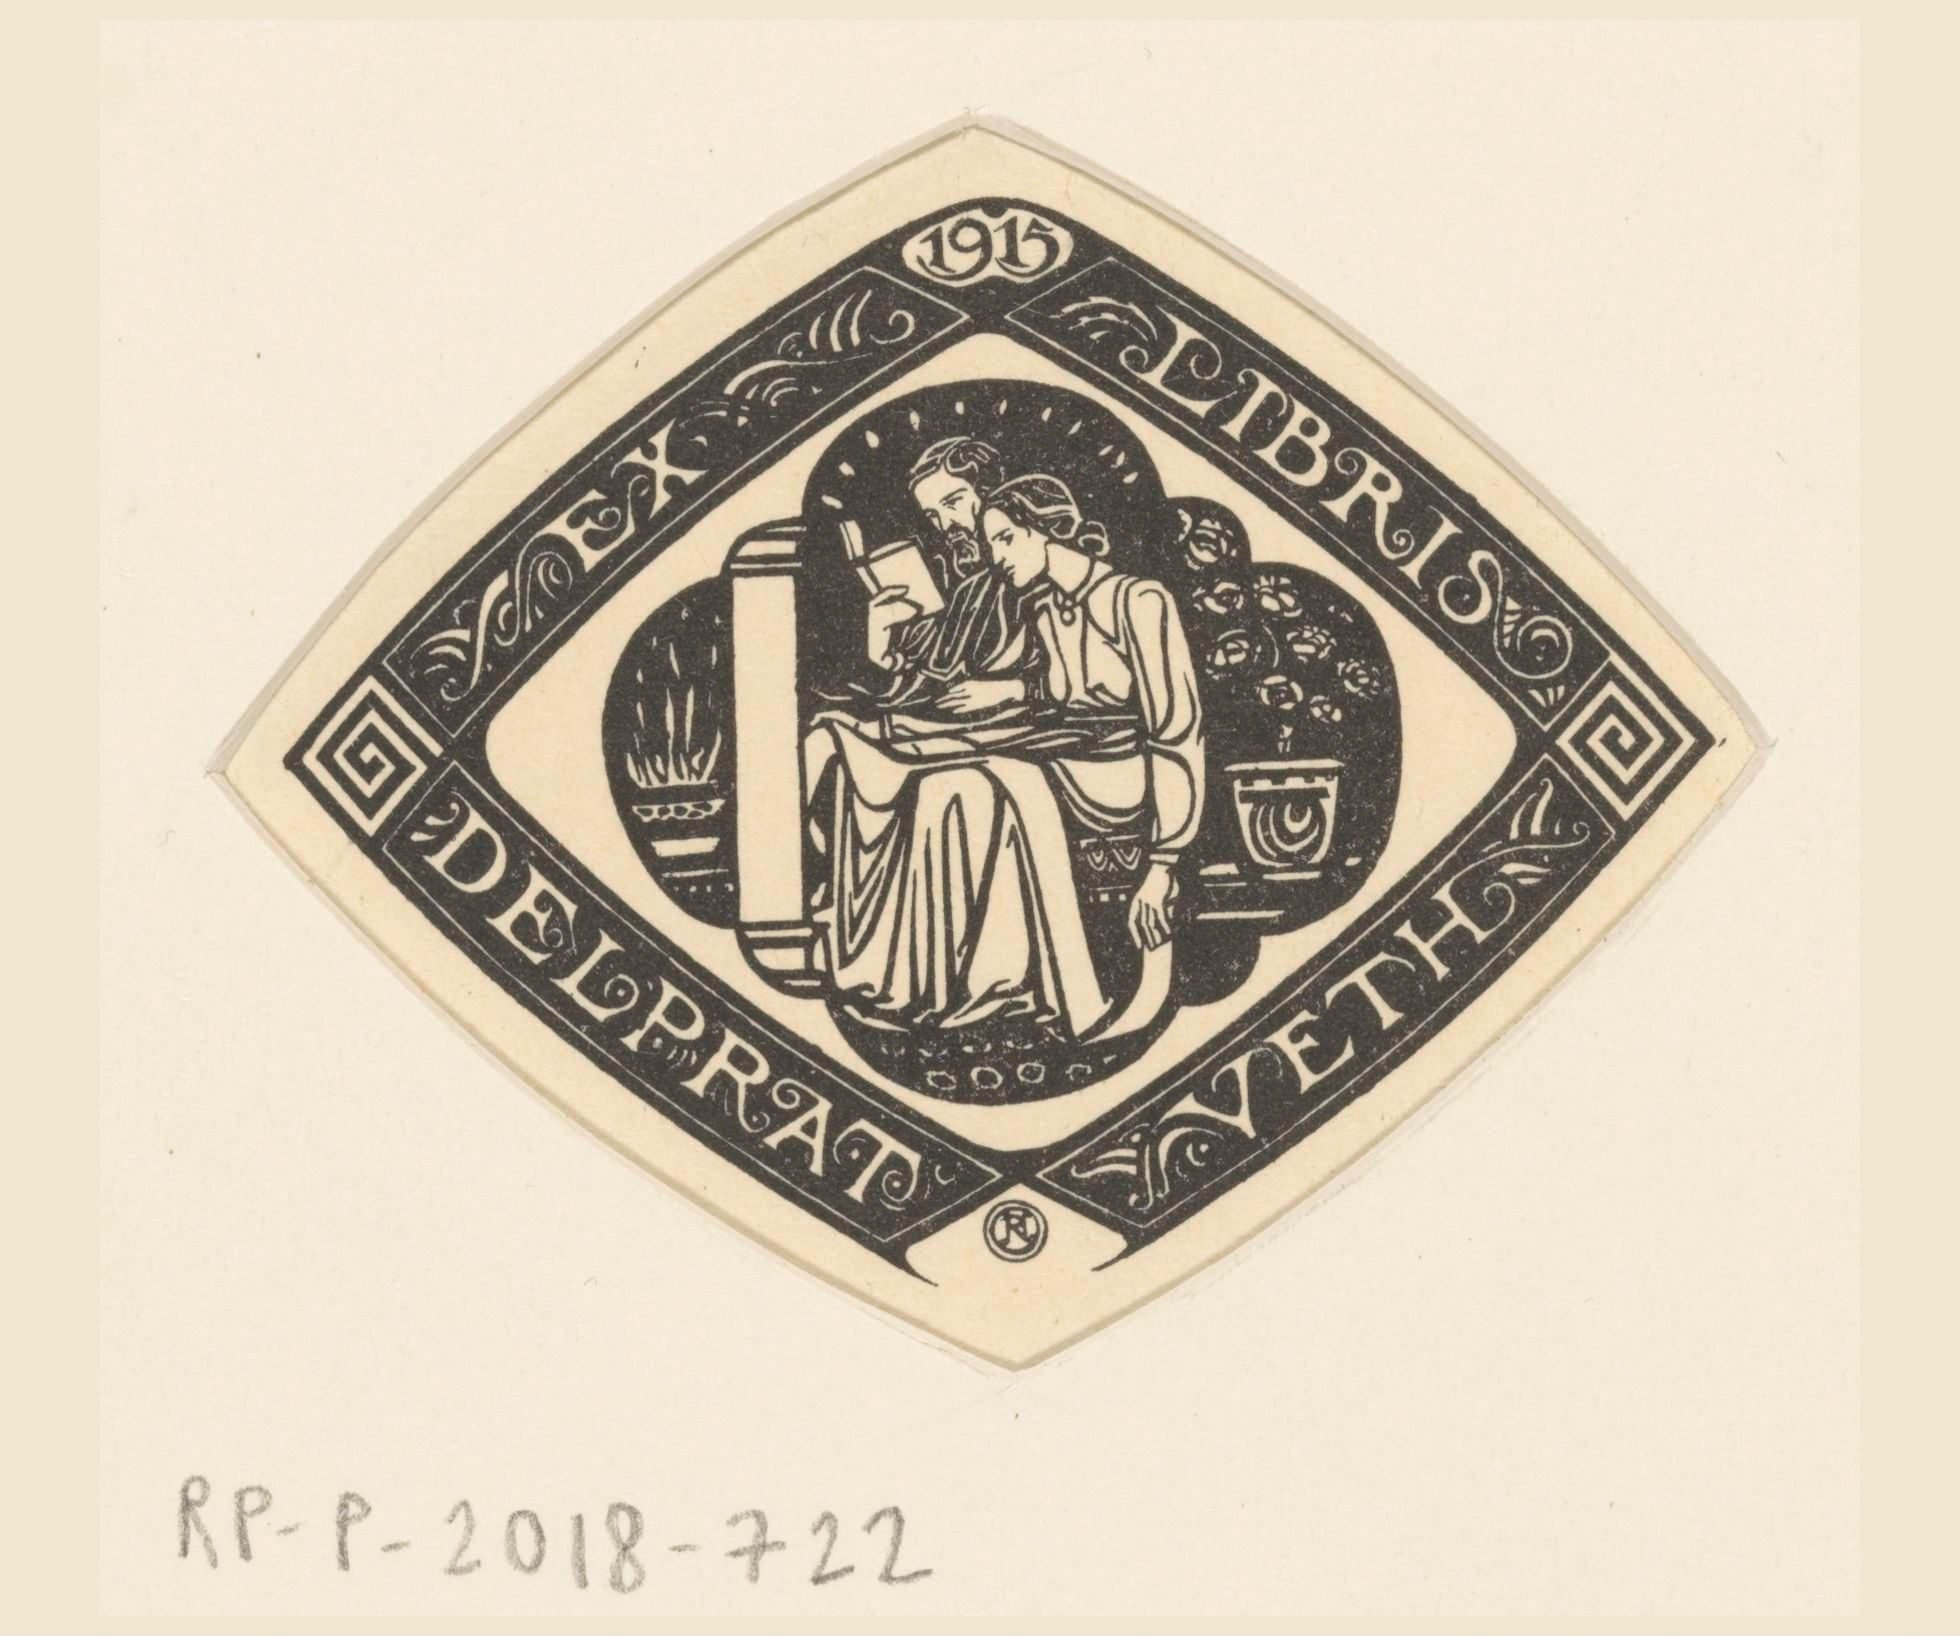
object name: print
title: Ex libris van Delprat-Veth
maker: richard nicolaüs roland holst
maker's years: 1868-1938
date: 1915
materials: paper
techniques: line block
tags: saskia delprat-veth, politician, daniel apollonius delprat, reading, book, couple of lovers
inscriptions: number: ‘16’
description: Een lezende man en vrouw in een tuin met rozen en een zuil.